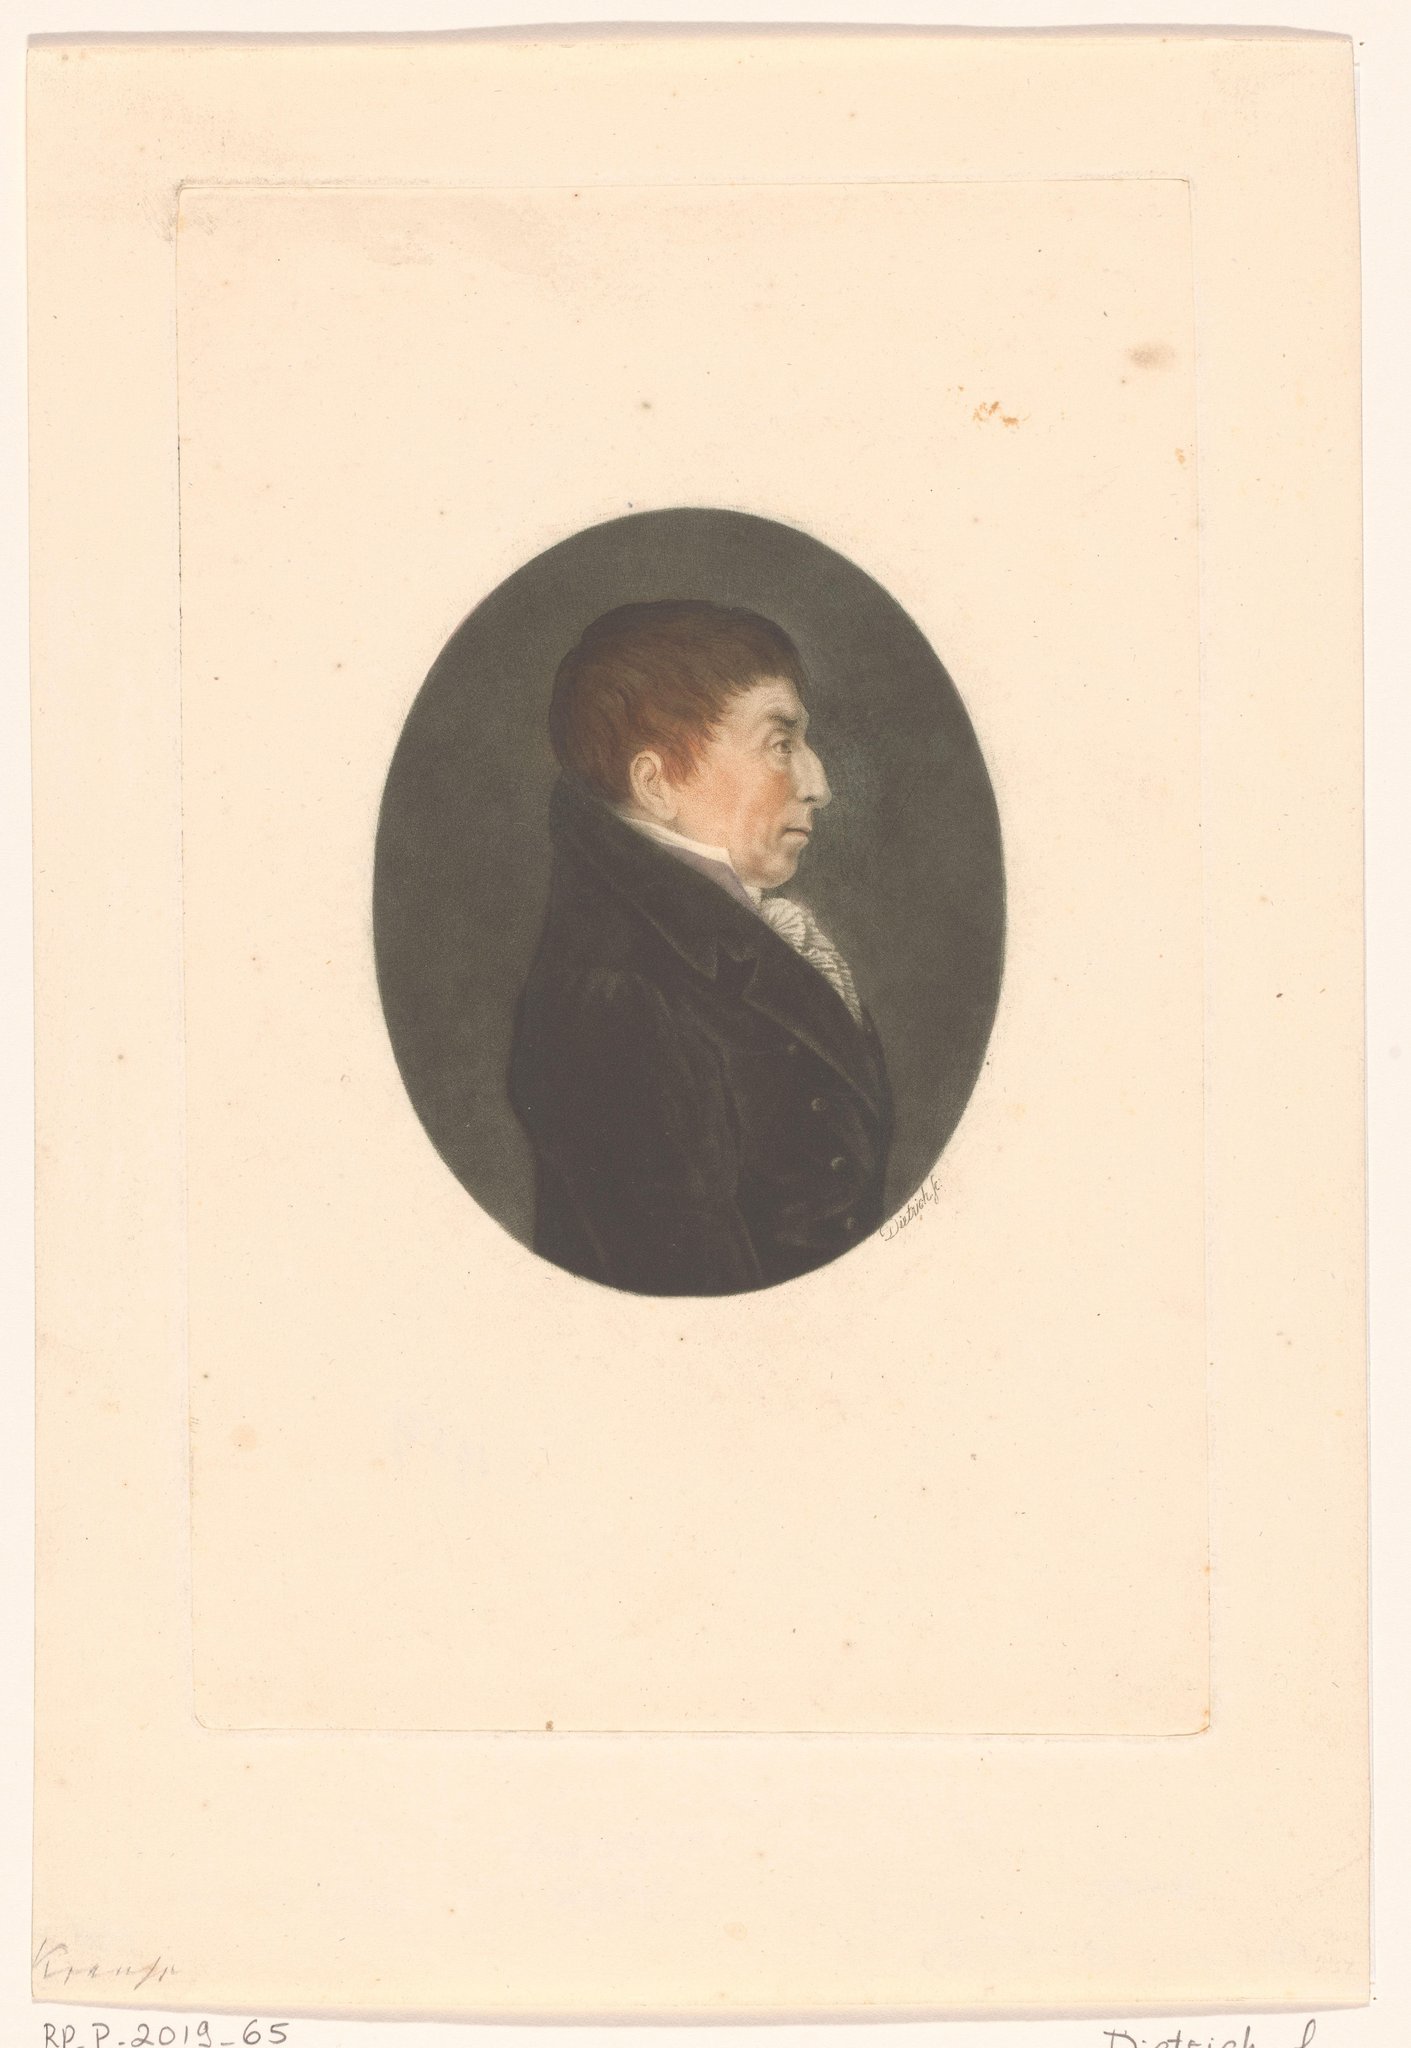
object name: print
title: Portret van arts Johan Carl Krauss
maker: friedrich christoph dietrich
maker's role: print maker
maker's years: 1779-1847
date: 1789-1826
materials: paper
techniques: etching, hand coloring, lithography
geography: germany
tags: leiden, historical persons, physician, doctor (+ portrait of scholar, scientist)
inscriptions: collector's mark: Lugt 2760, collector's mark: Lugt 2228